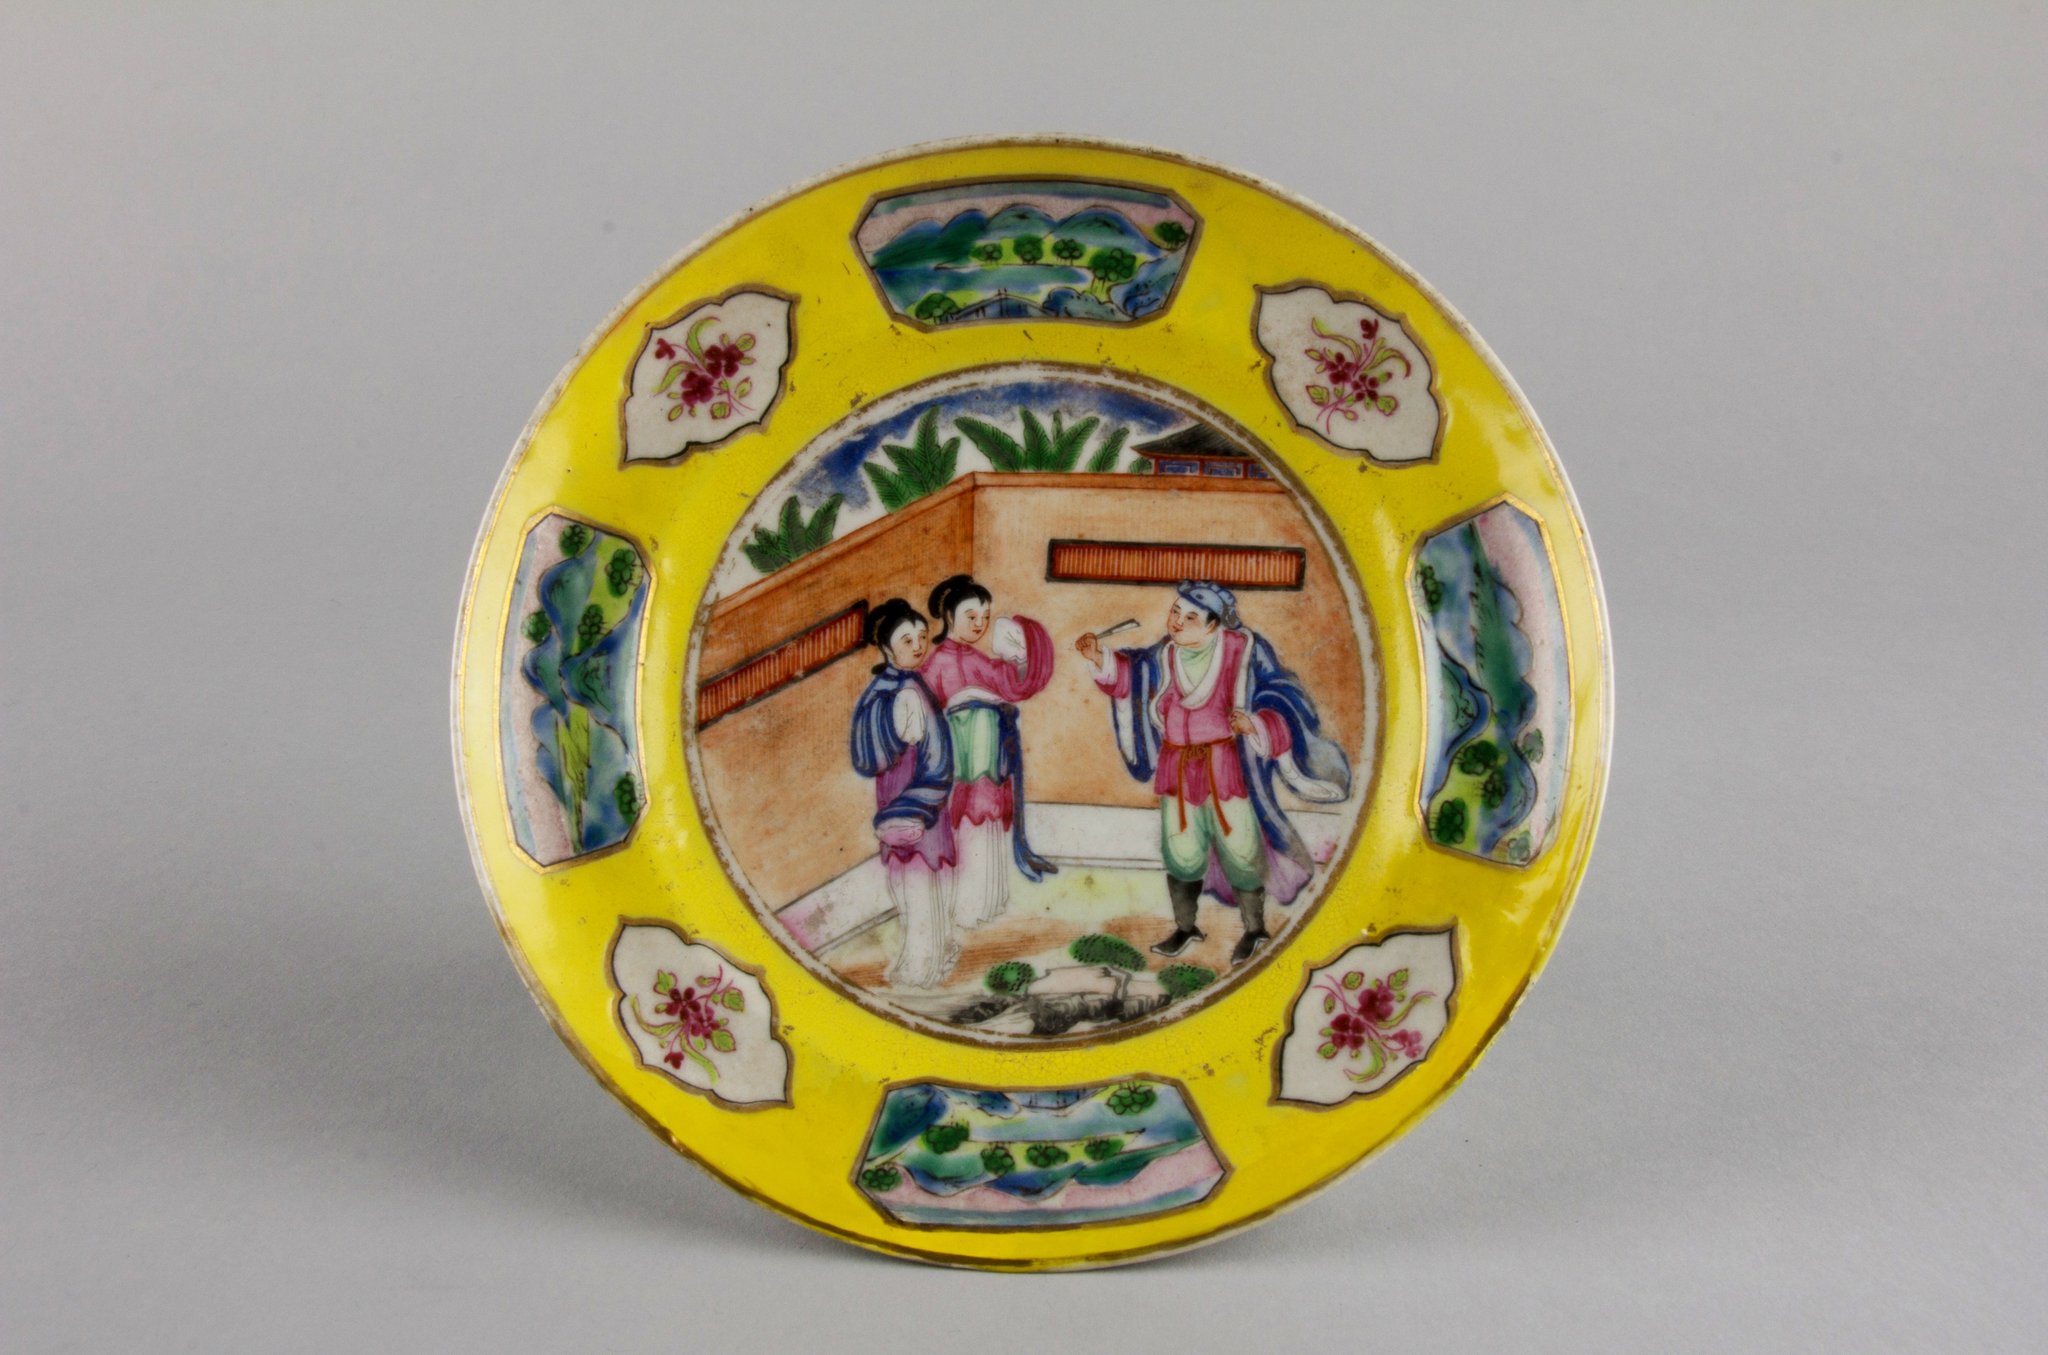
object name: dish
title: Dish with figures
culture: chinese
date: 1801-1900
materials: enamel, porcelain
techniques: overglaze, painting, polychrome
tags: men,women